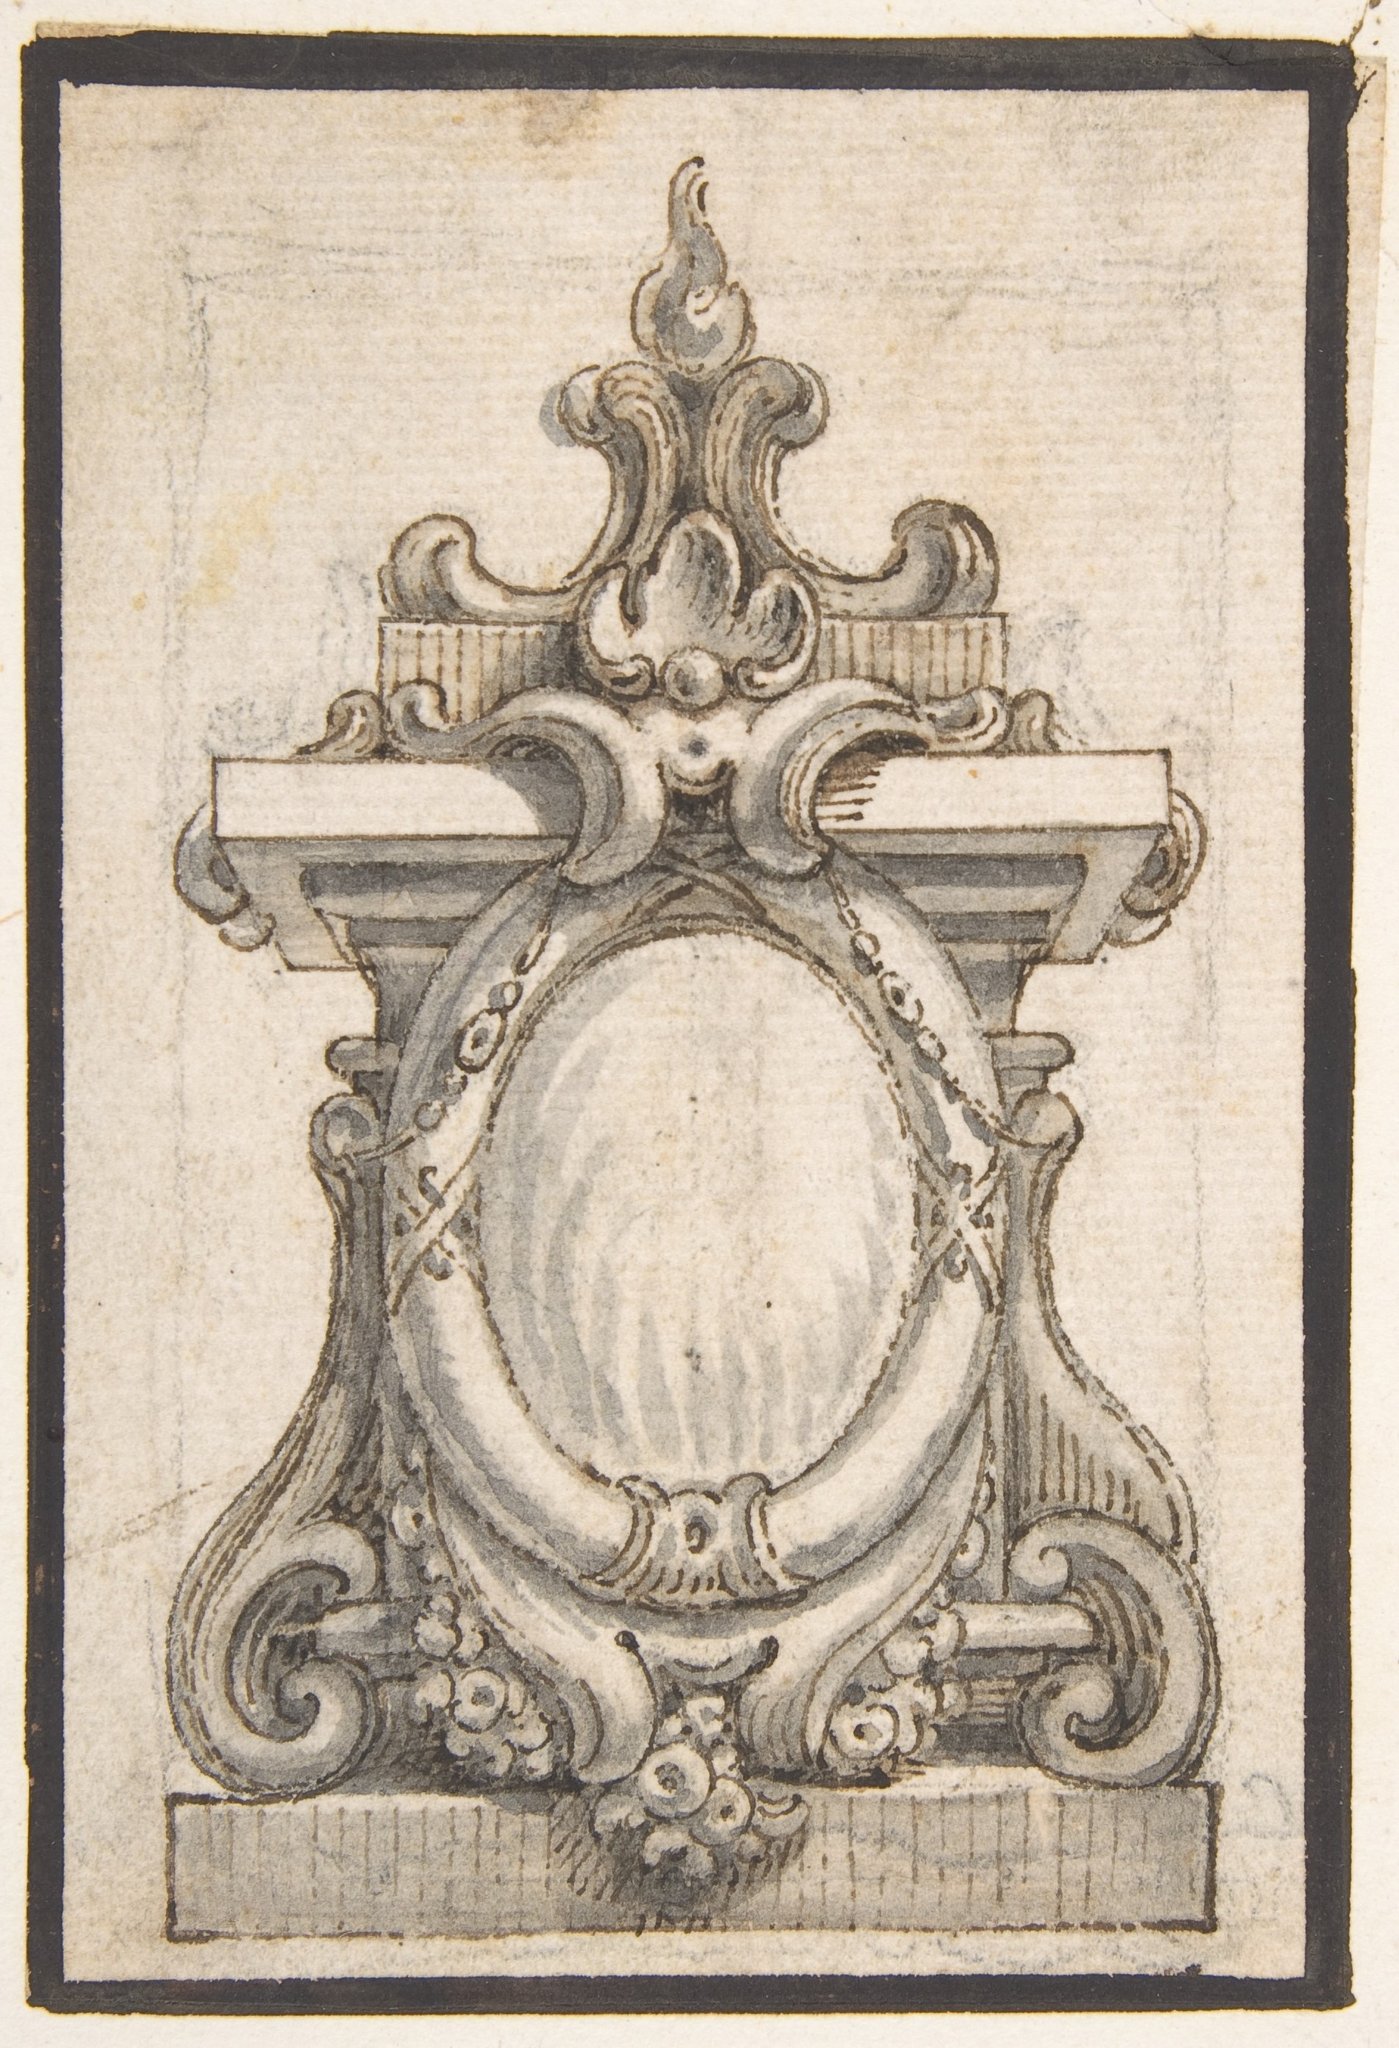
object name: drawing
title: Design for a Cartouche with an Oval Compartment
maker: anonymous, italian, 18th century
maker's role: artist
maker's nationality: italian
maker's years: 1700-1800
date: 1701-1800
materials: chalk, ink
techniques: brush, pen, wash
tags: cartouches